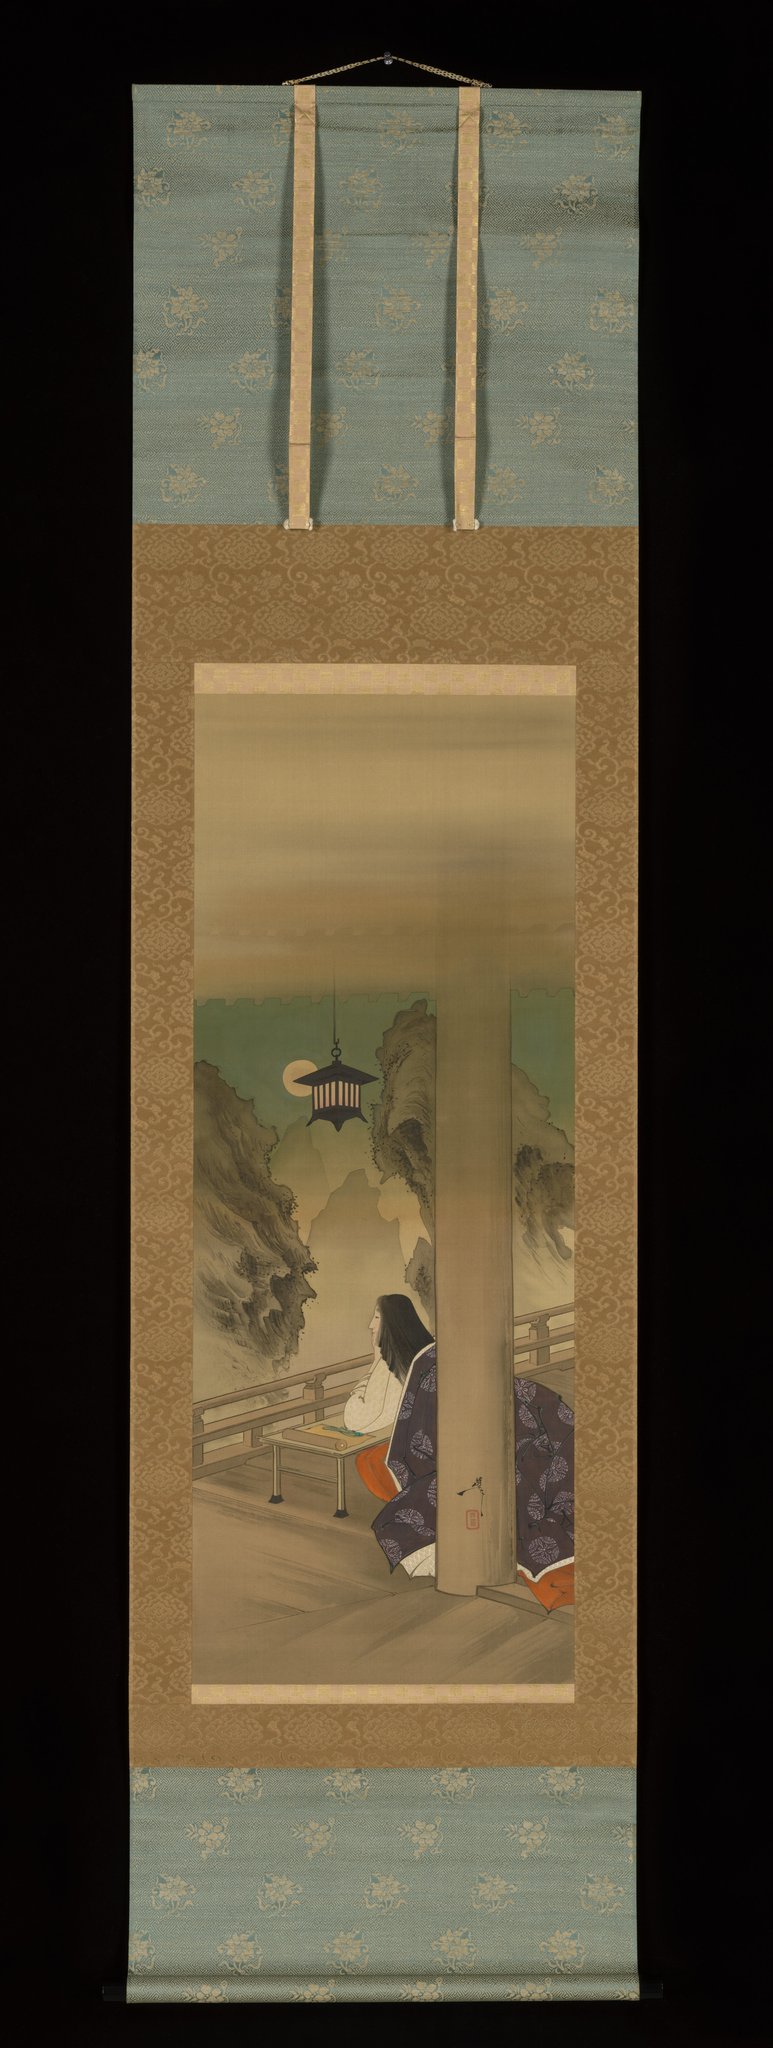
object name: hanging scroll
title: Murasaki Shikibu at Ishiyamadera Temple, based on the print “The Moon at Ishiyama,” from the series One Hundred Aspects of the Moon (Tsuki hyakushi: Ishiyama no tsuki)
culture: japanese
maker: tsukioka yoshitoshi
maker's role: artist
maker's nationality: japanese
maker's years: 1839-1892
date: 1892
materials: ink, silk